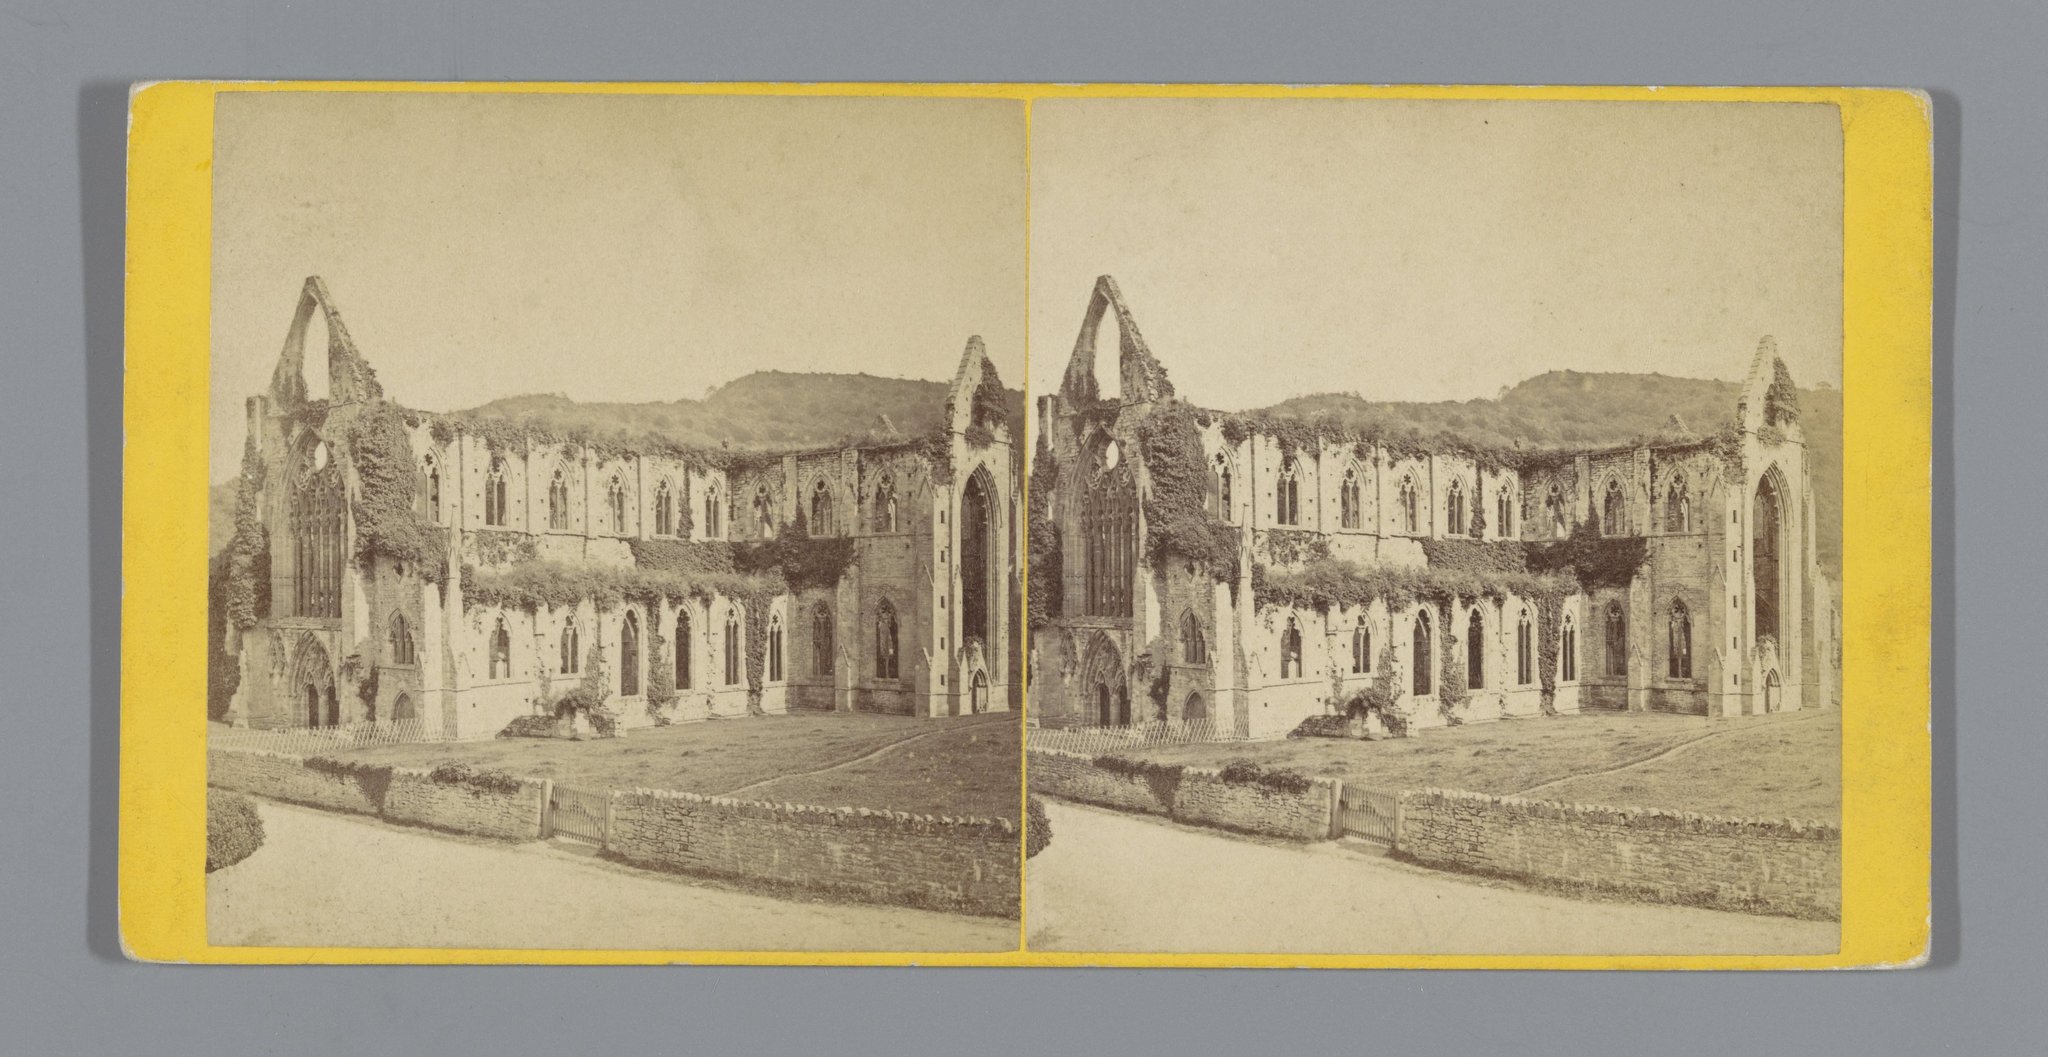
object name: stereograph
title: Tintern Abbey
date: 1858-1872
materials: cardboard, photographic support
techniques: albumen print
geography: tintern abbey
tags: abbey, monastery, convent ~ roman catholic church, ruin of church, monastery, etc.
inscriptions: number: ‘No. 1204.’